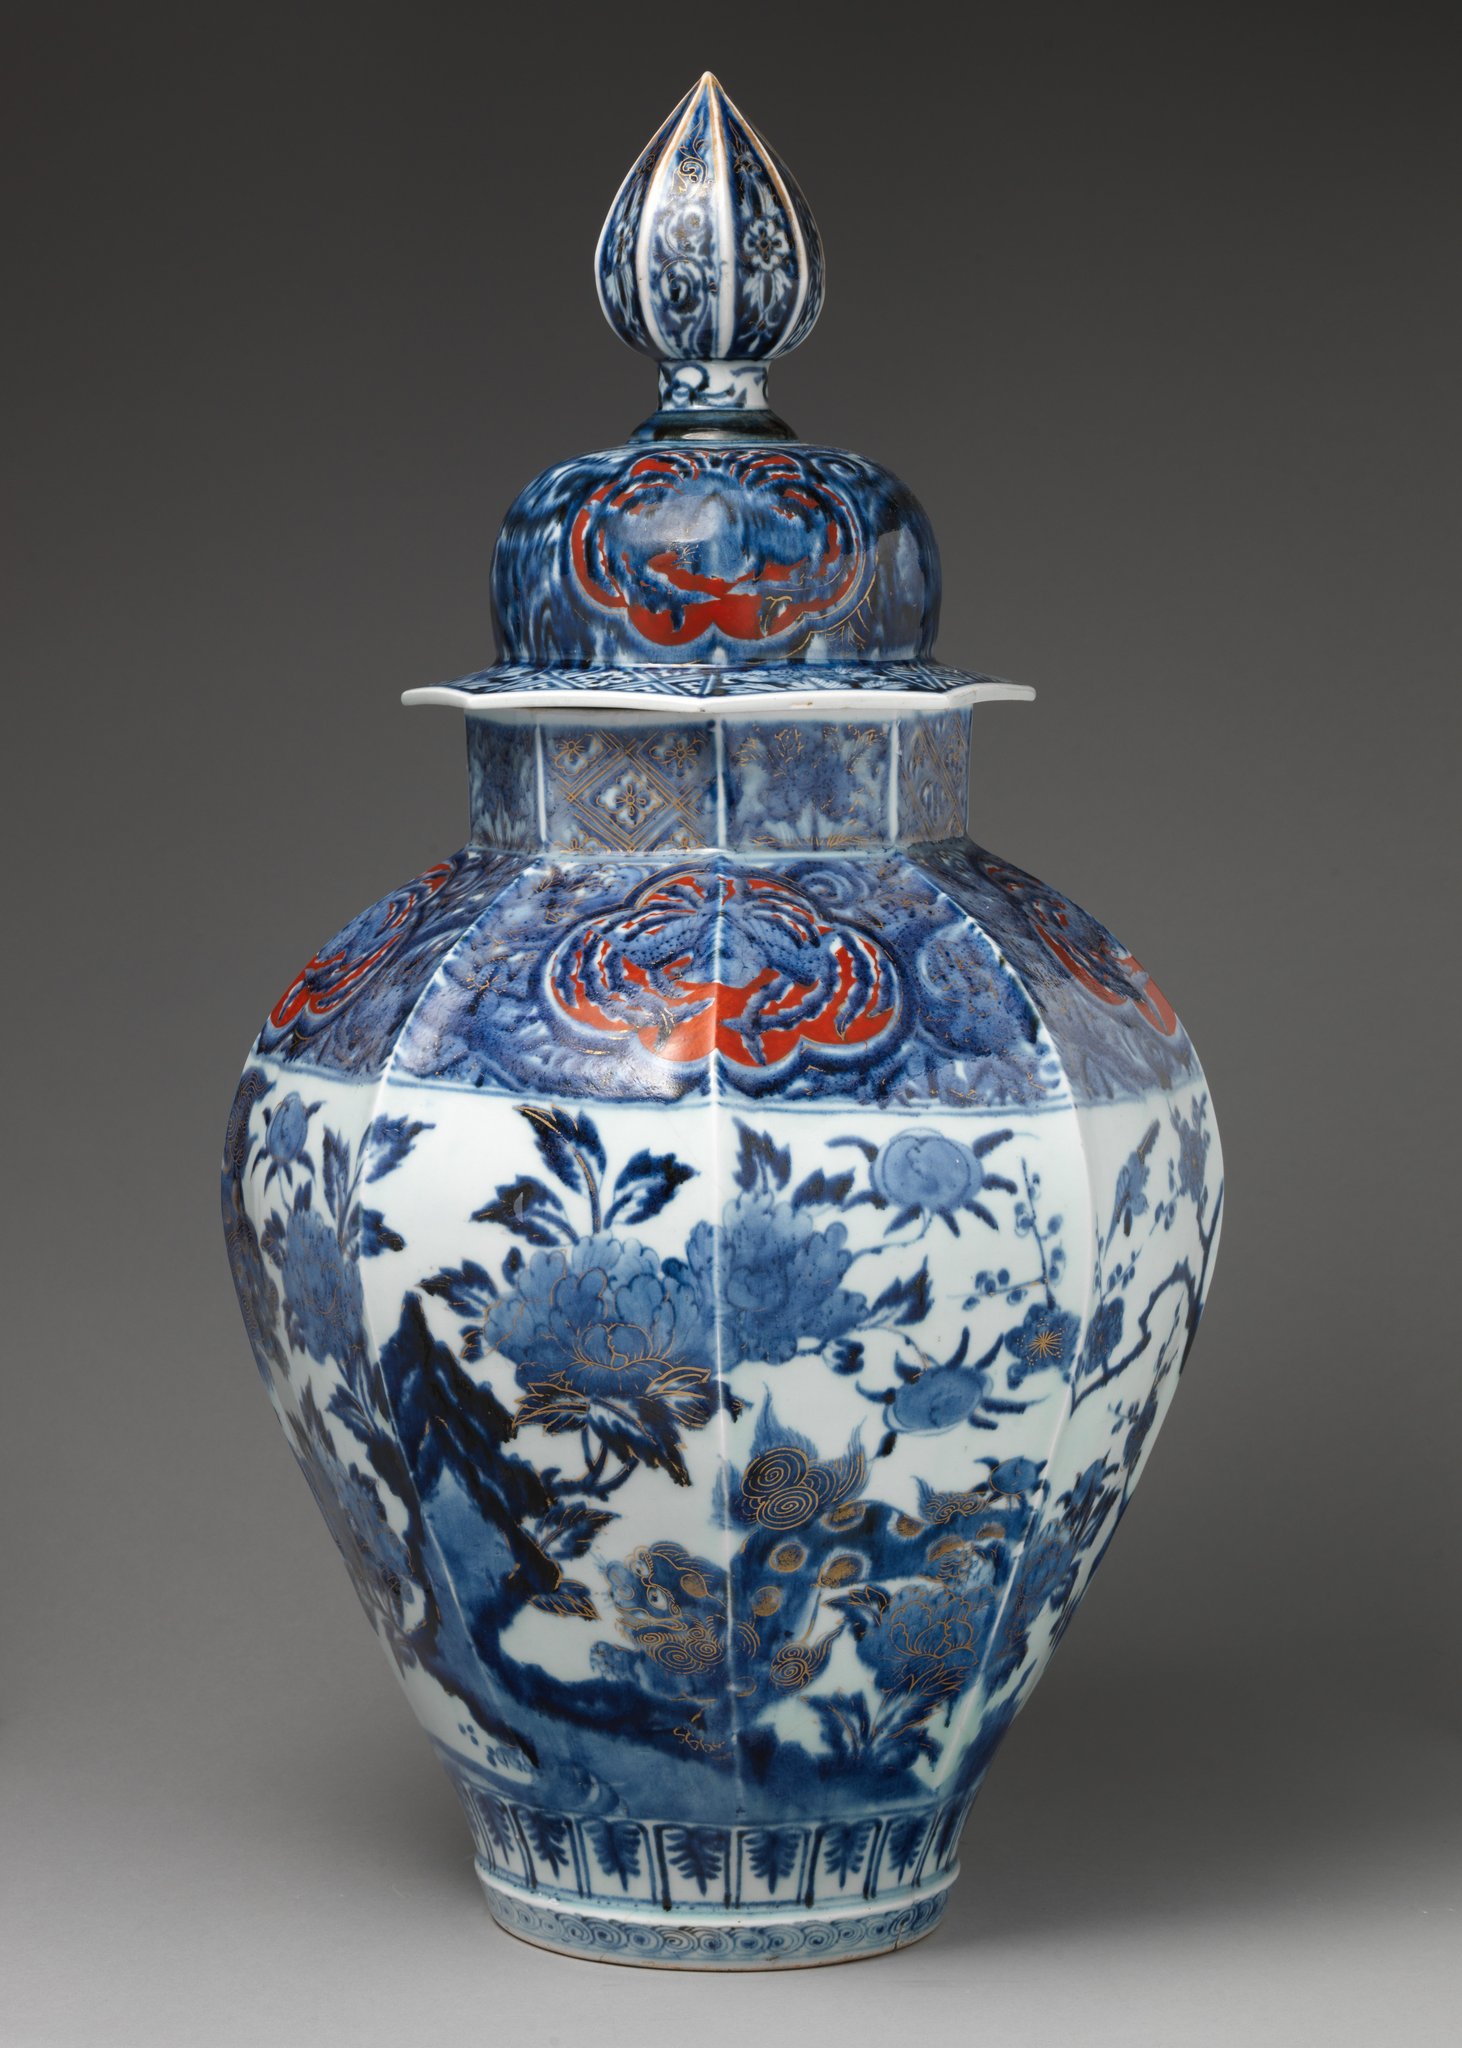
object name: covered jar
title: Covered jar with large finial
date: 1725-1750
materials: porcelain